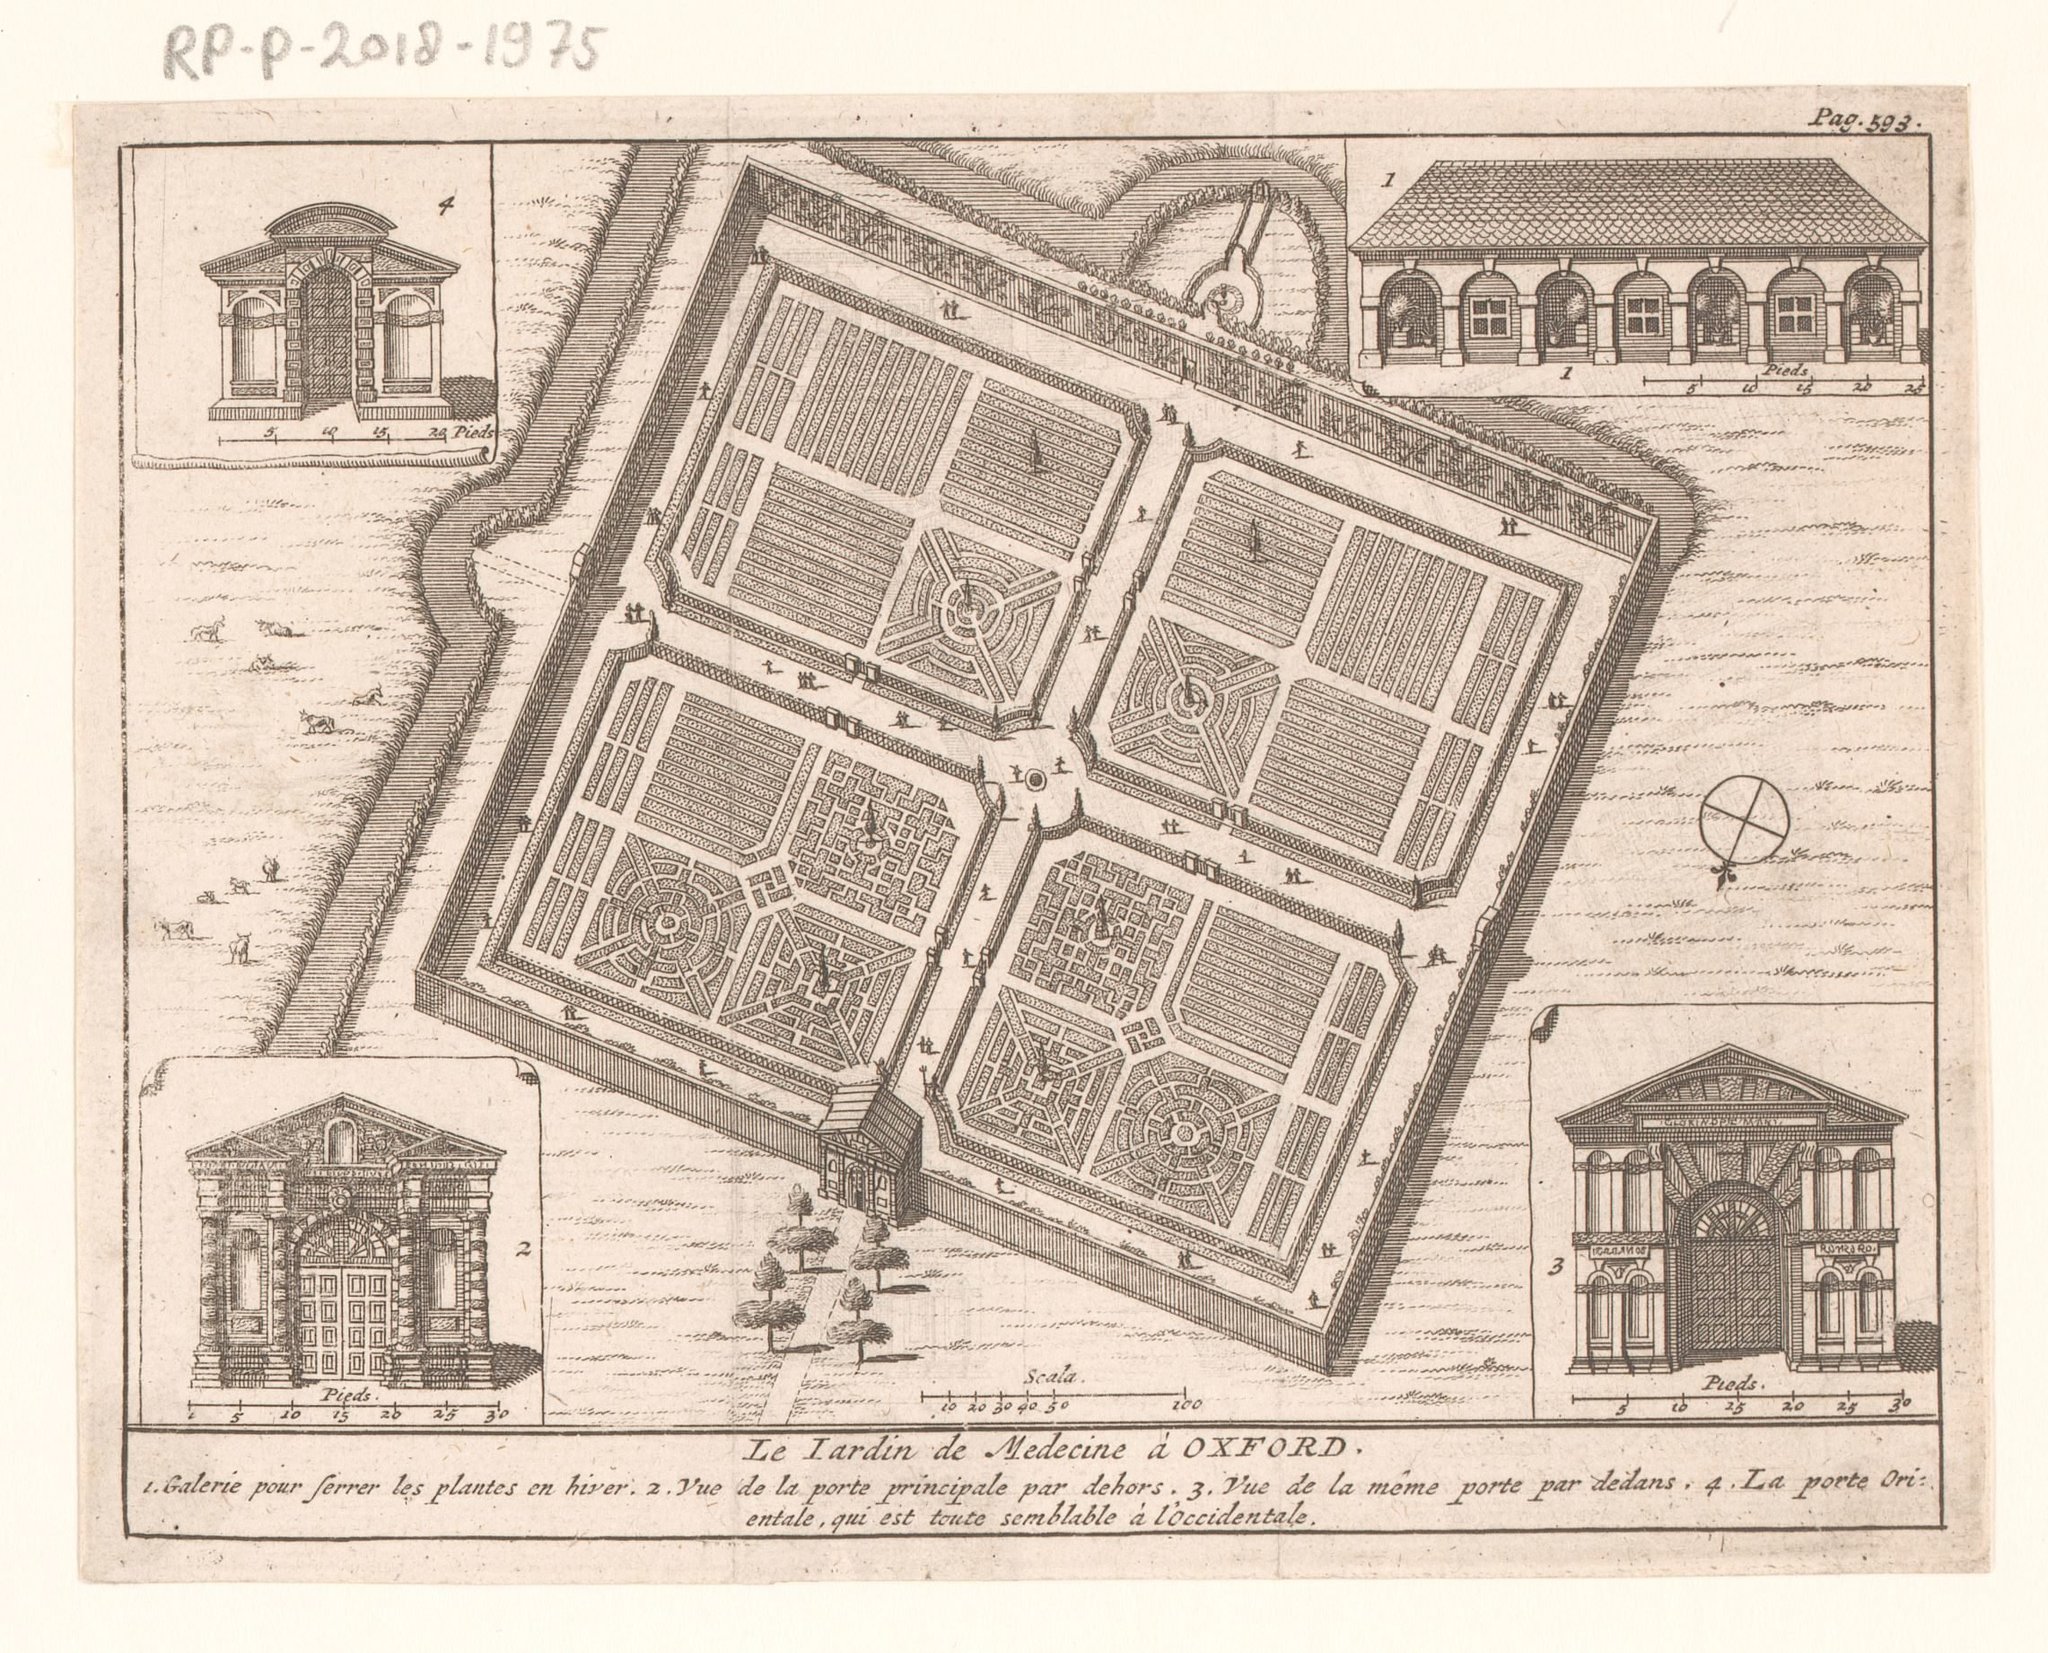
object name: area plan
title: Le Iardin de Medecine à Oxford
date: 1707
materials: paper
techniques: etching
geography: leiden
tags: botanic garden, 'hortus botanicus'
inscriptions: collector's mark: Lugt 2228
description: Prent gebruikt in: Beeverell, James. Les Delices de la Grande Bretagne et de l'Irlande (...). Leiden: Pieter van der Aa, 1707.